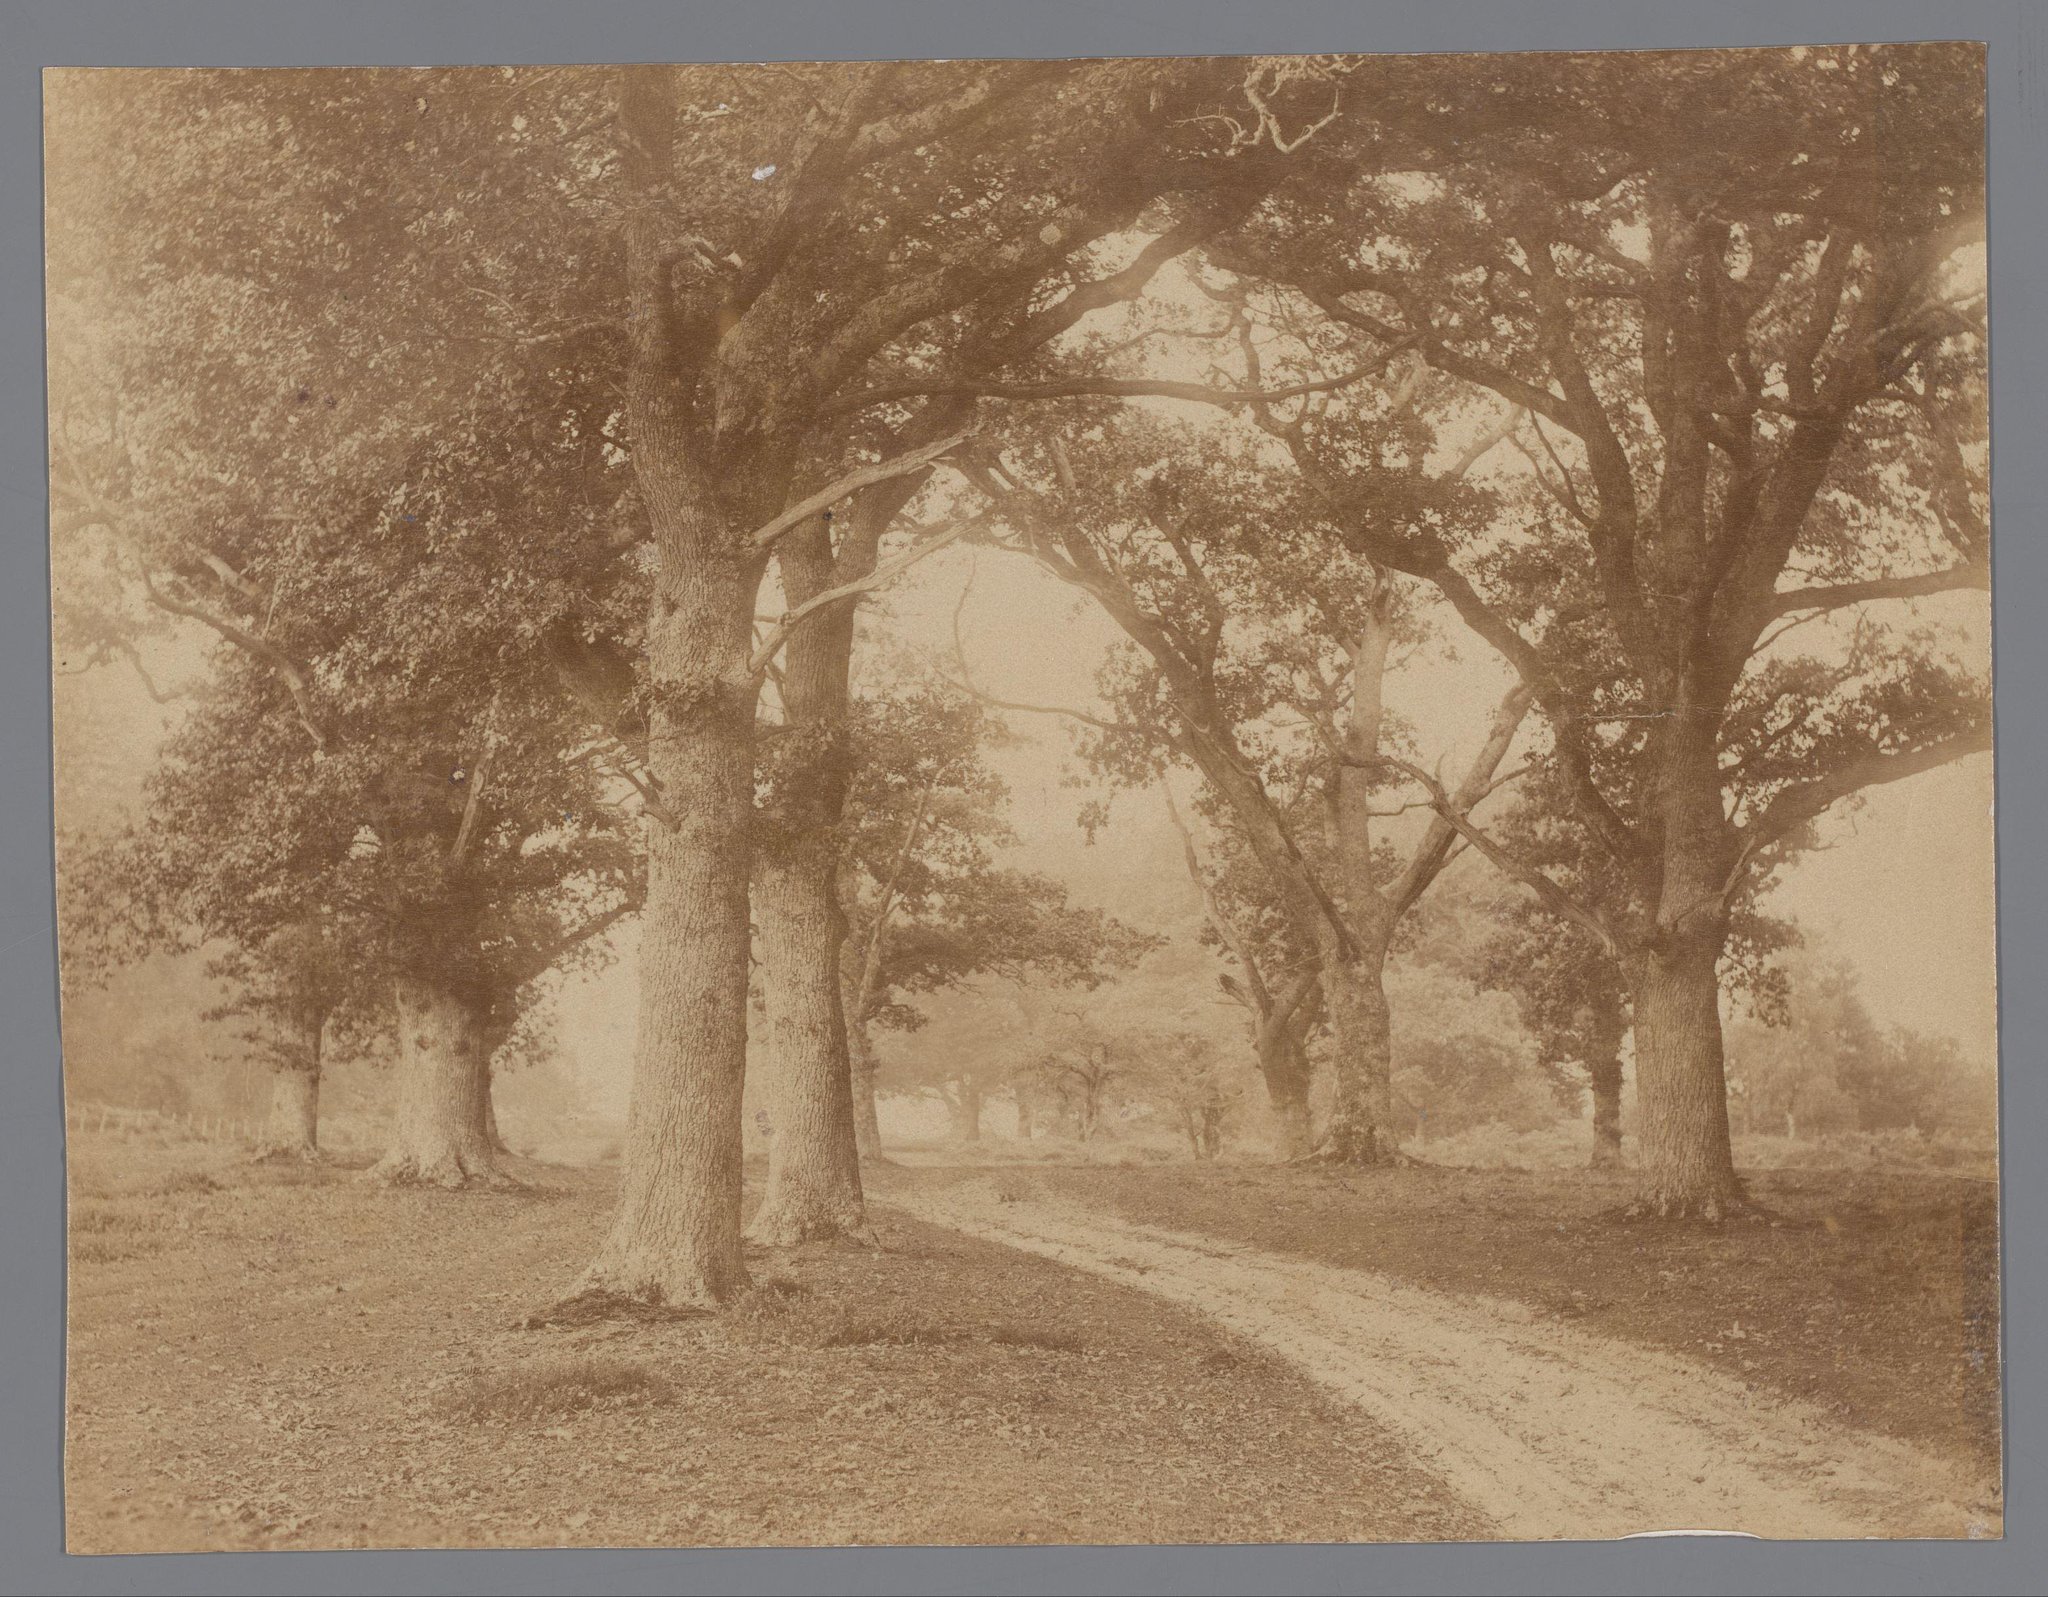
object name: photograph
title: Landschap met een pad en bomen aan weerszijden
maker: Anonymous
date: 1870-1890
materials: paper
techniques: albumen print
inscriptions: inscription: ‘O.O.’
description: Landschap met een pad en bomen aan weerszijden.